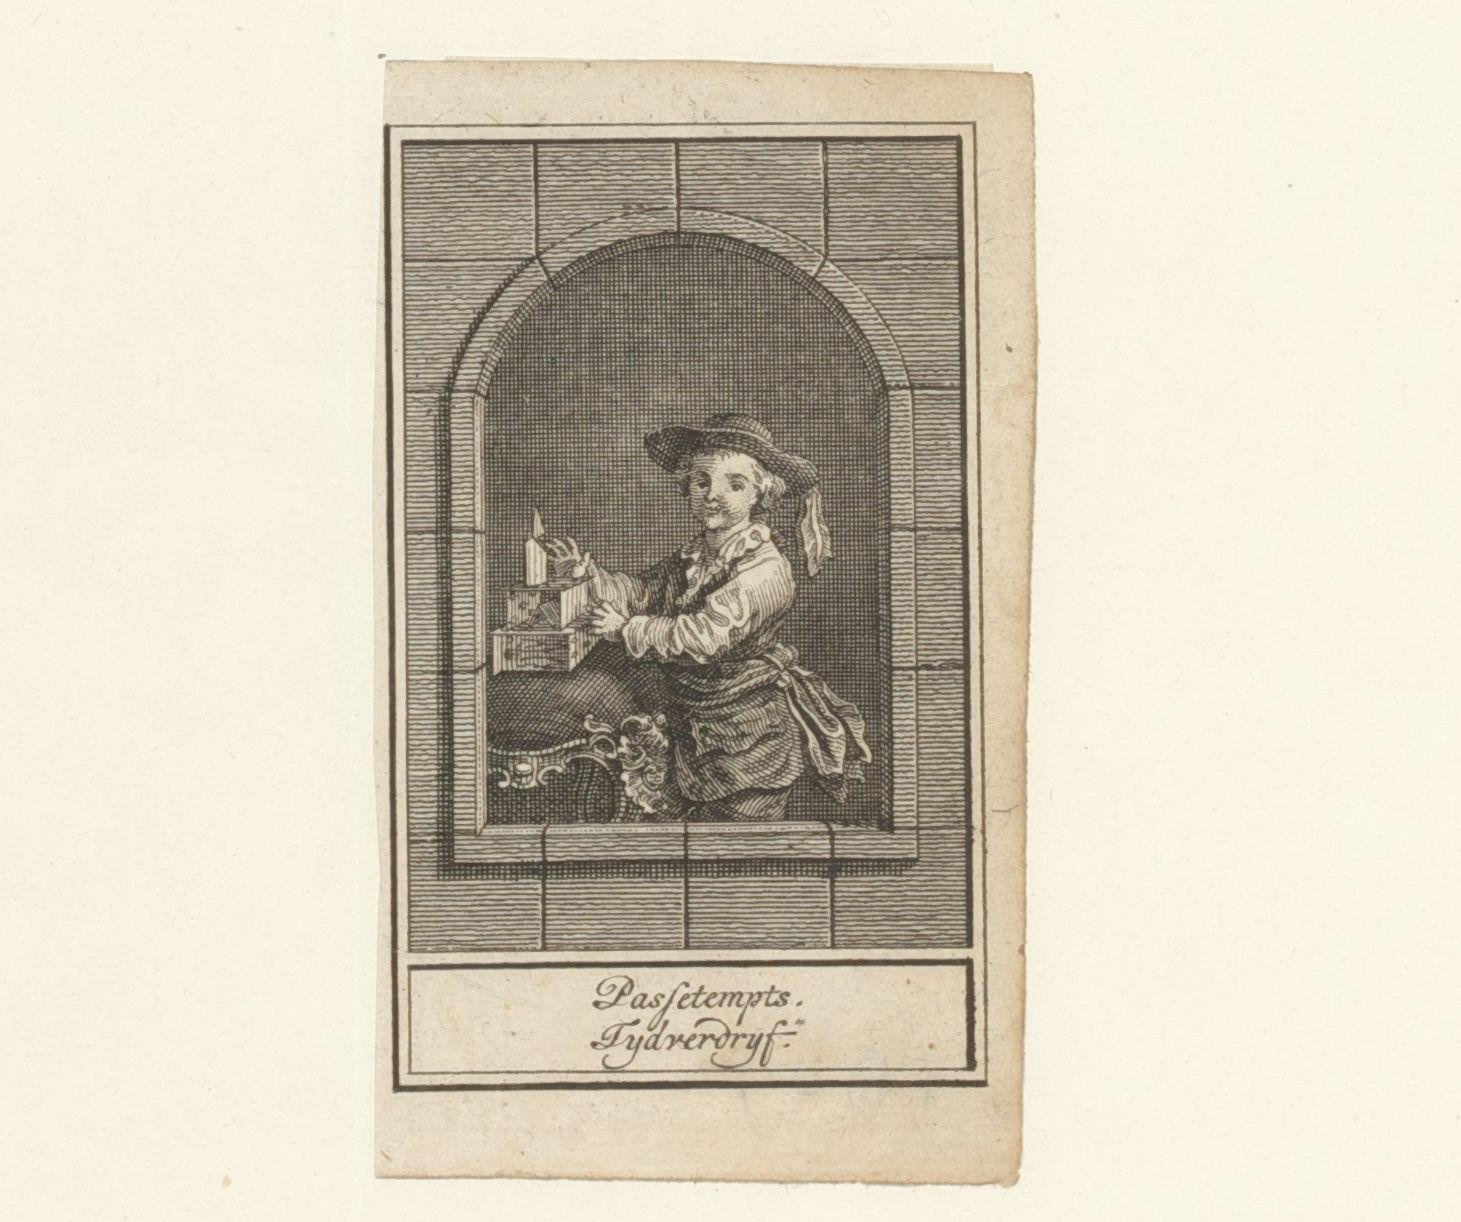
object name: print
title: Jongen speelt met een kistje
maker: Anonymous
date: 1700-1799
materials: paper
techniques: engraving, etching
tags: children's games and plays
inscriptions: collector's mark: Lugt 1641, stamp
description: Onderwerpsrubrieken binnen de Atlas Zeden en Gewoonten: Zeden en Gewoonten in Engeren Zin, Des menschen beging, midden en einde, Kinderleven – Kinderspel en Kinderprenten.